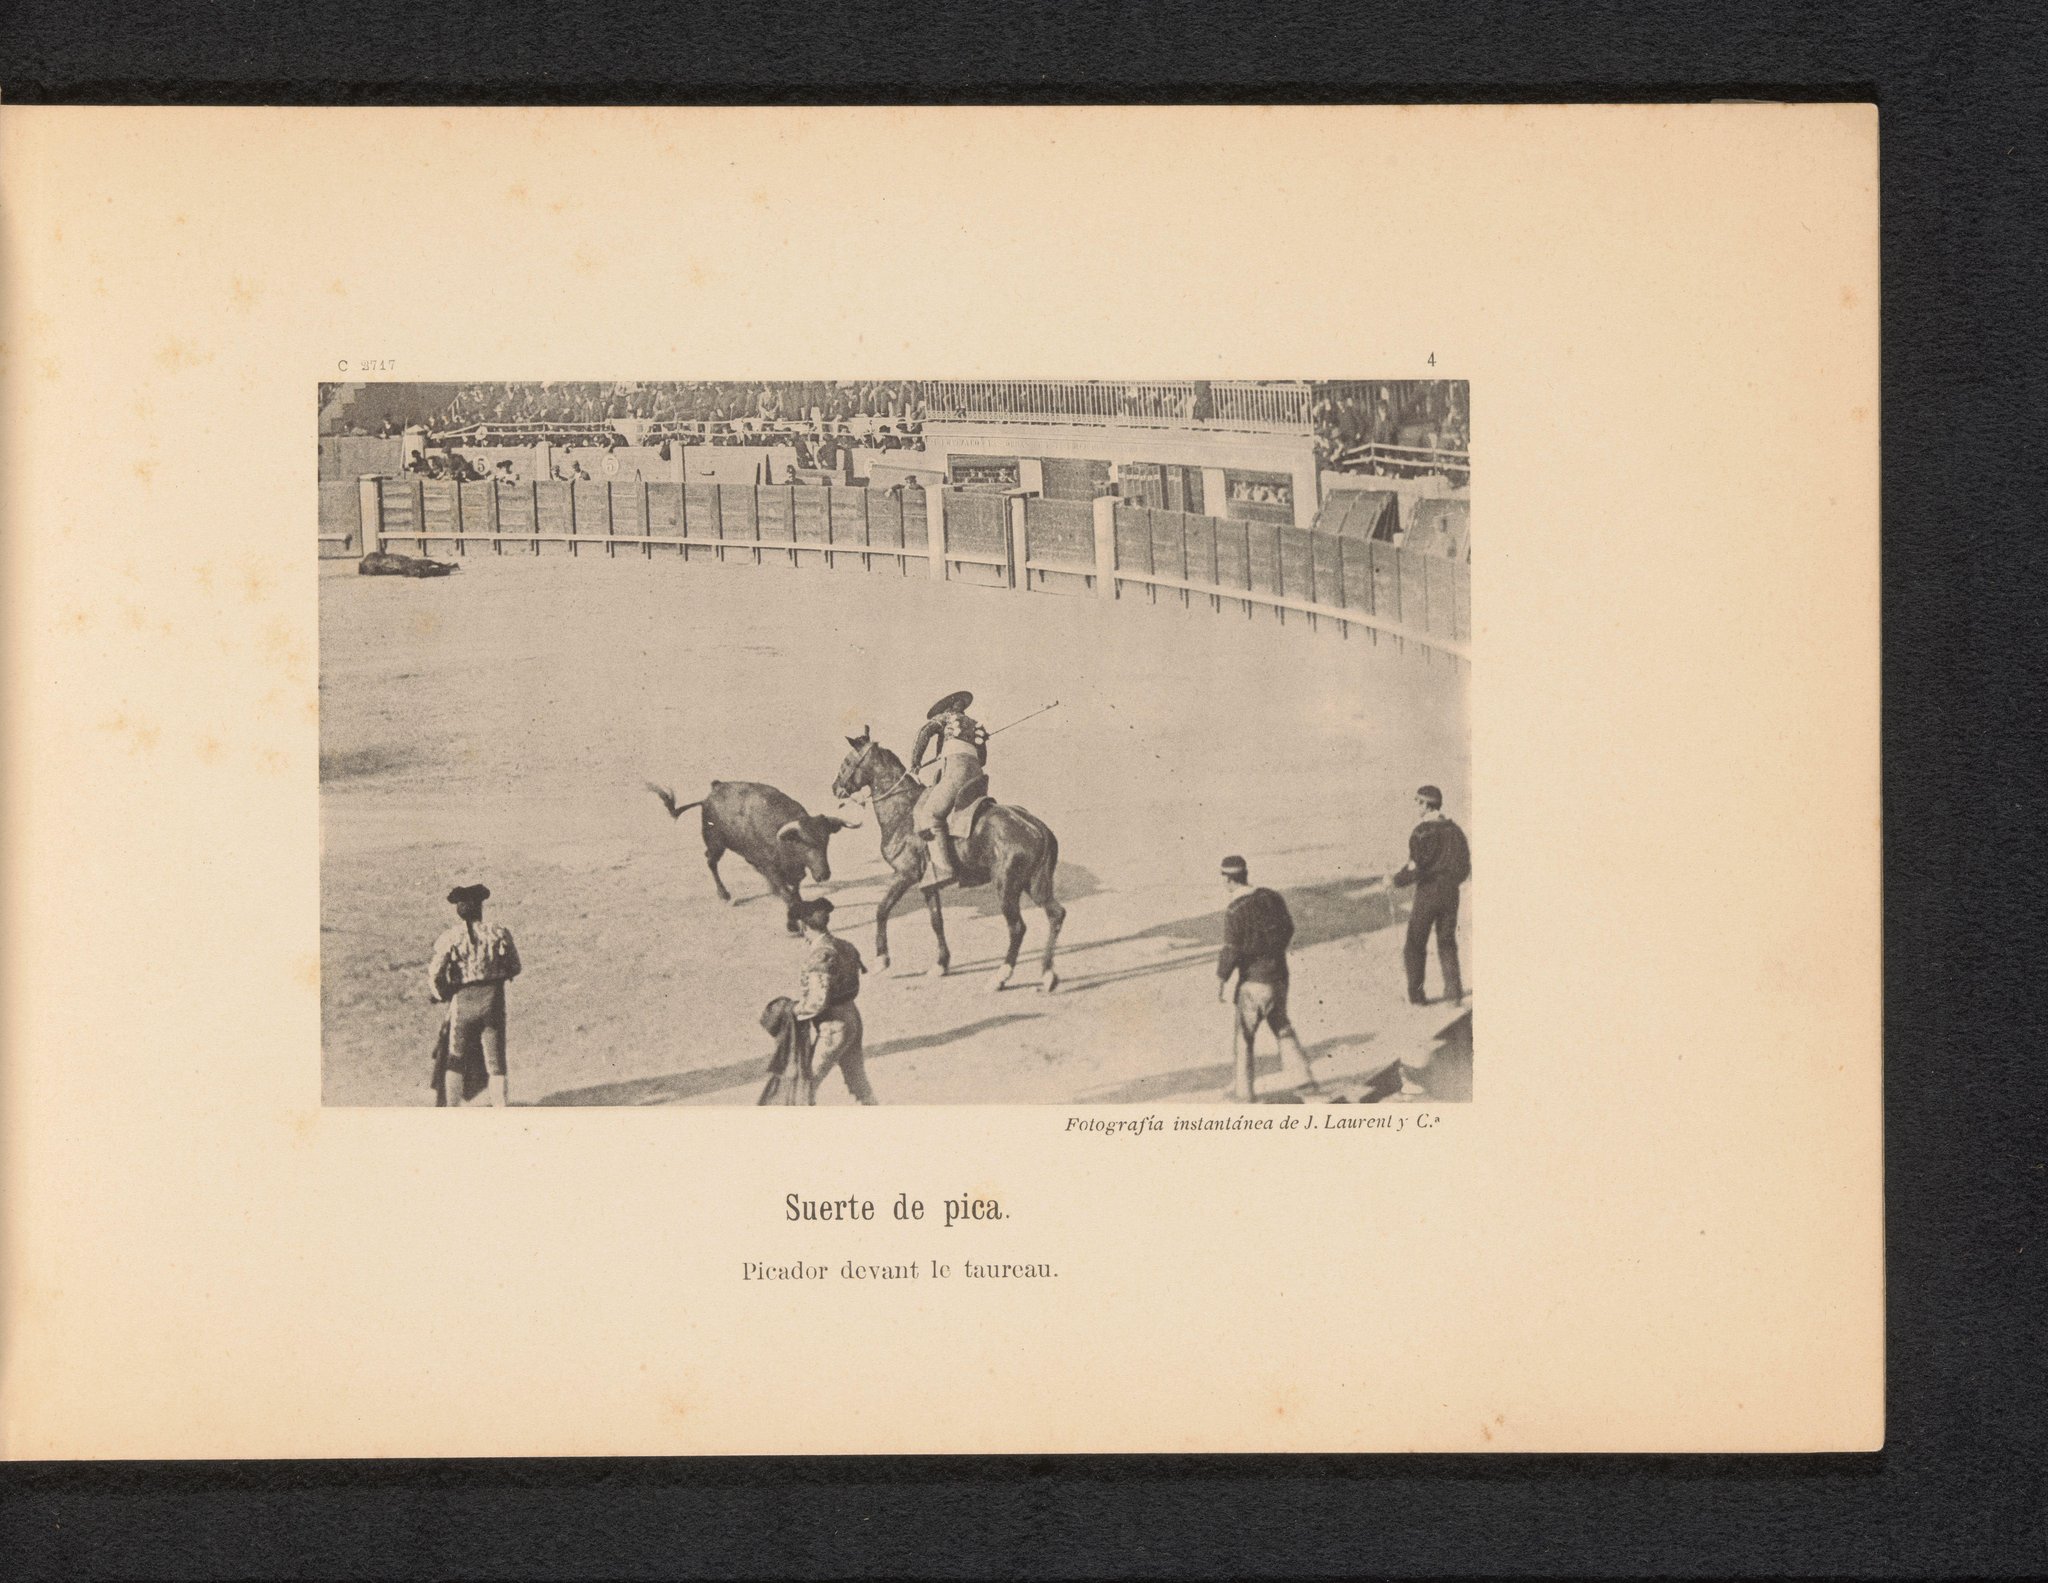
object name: page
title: Suerte de pica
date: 1880-1890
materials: paper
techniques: photograph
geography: madrid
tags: bullfight, bull-fighter, toreador, theatre (building) - aa - open-air performances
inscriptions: number: ‘4’, number: ‘C. 2717’